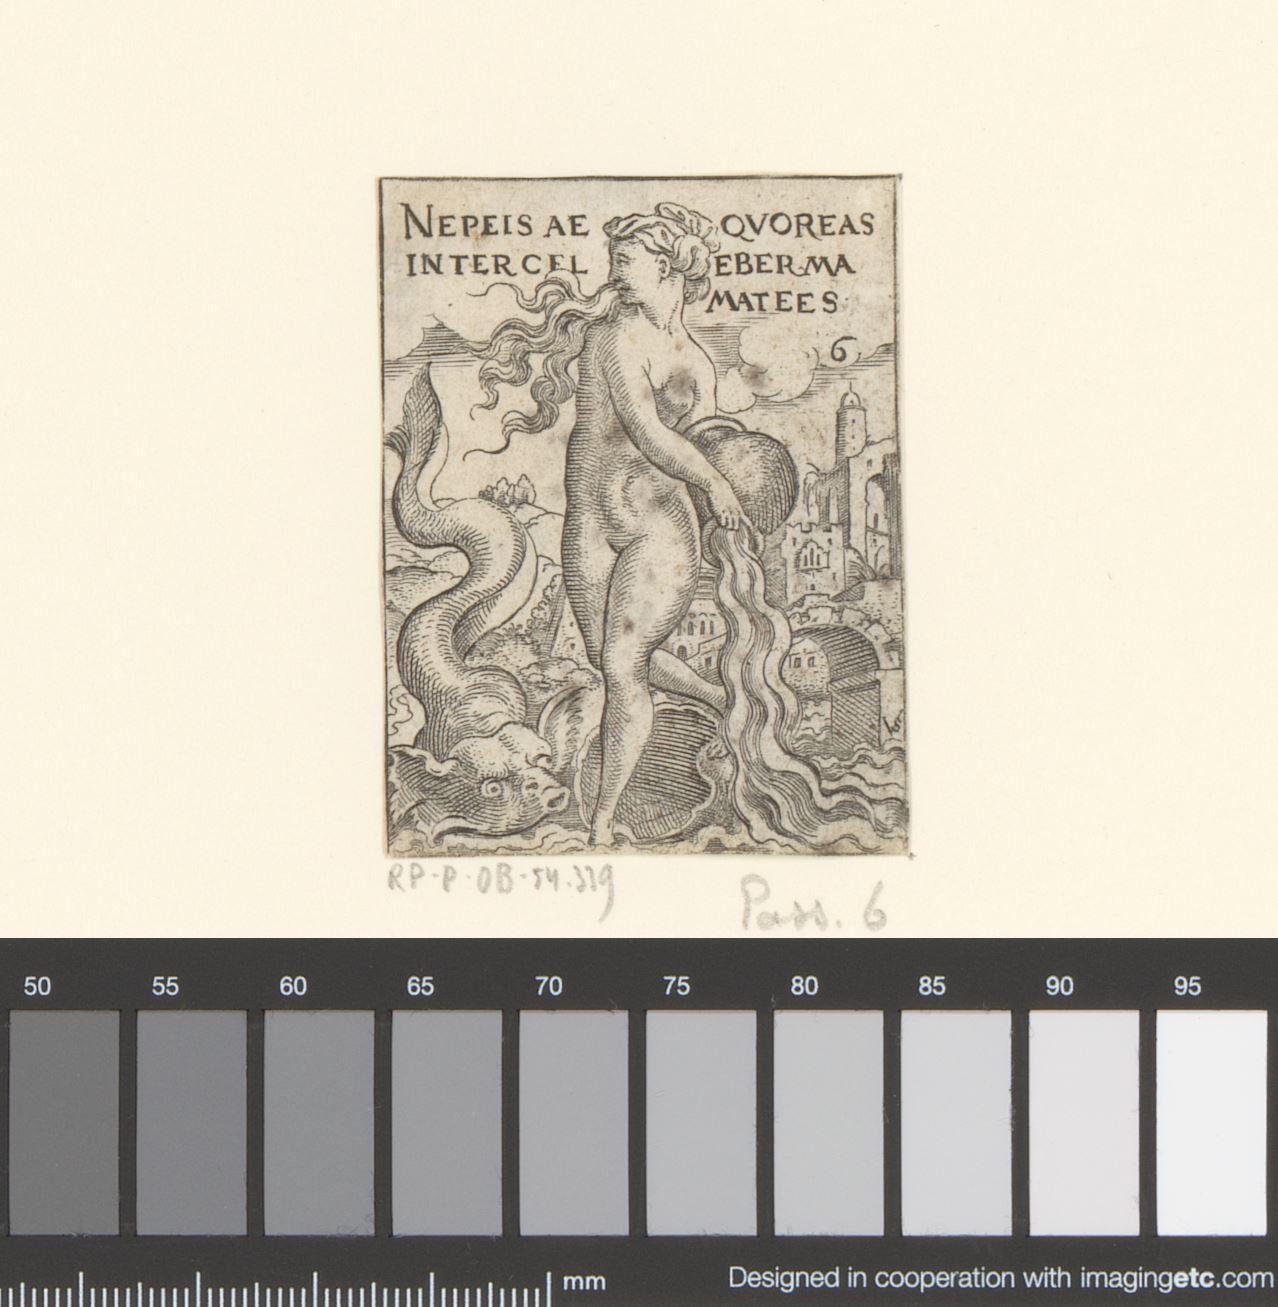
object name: print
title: Thetis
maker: nikolaus solis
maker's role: print maker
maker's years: 1542-1584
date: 1552-1584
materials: paper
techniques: engraving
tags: (story of) thetis; 'thethi, ninfa del mare' (ripa)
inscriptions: collector's mark: Lugt 2228